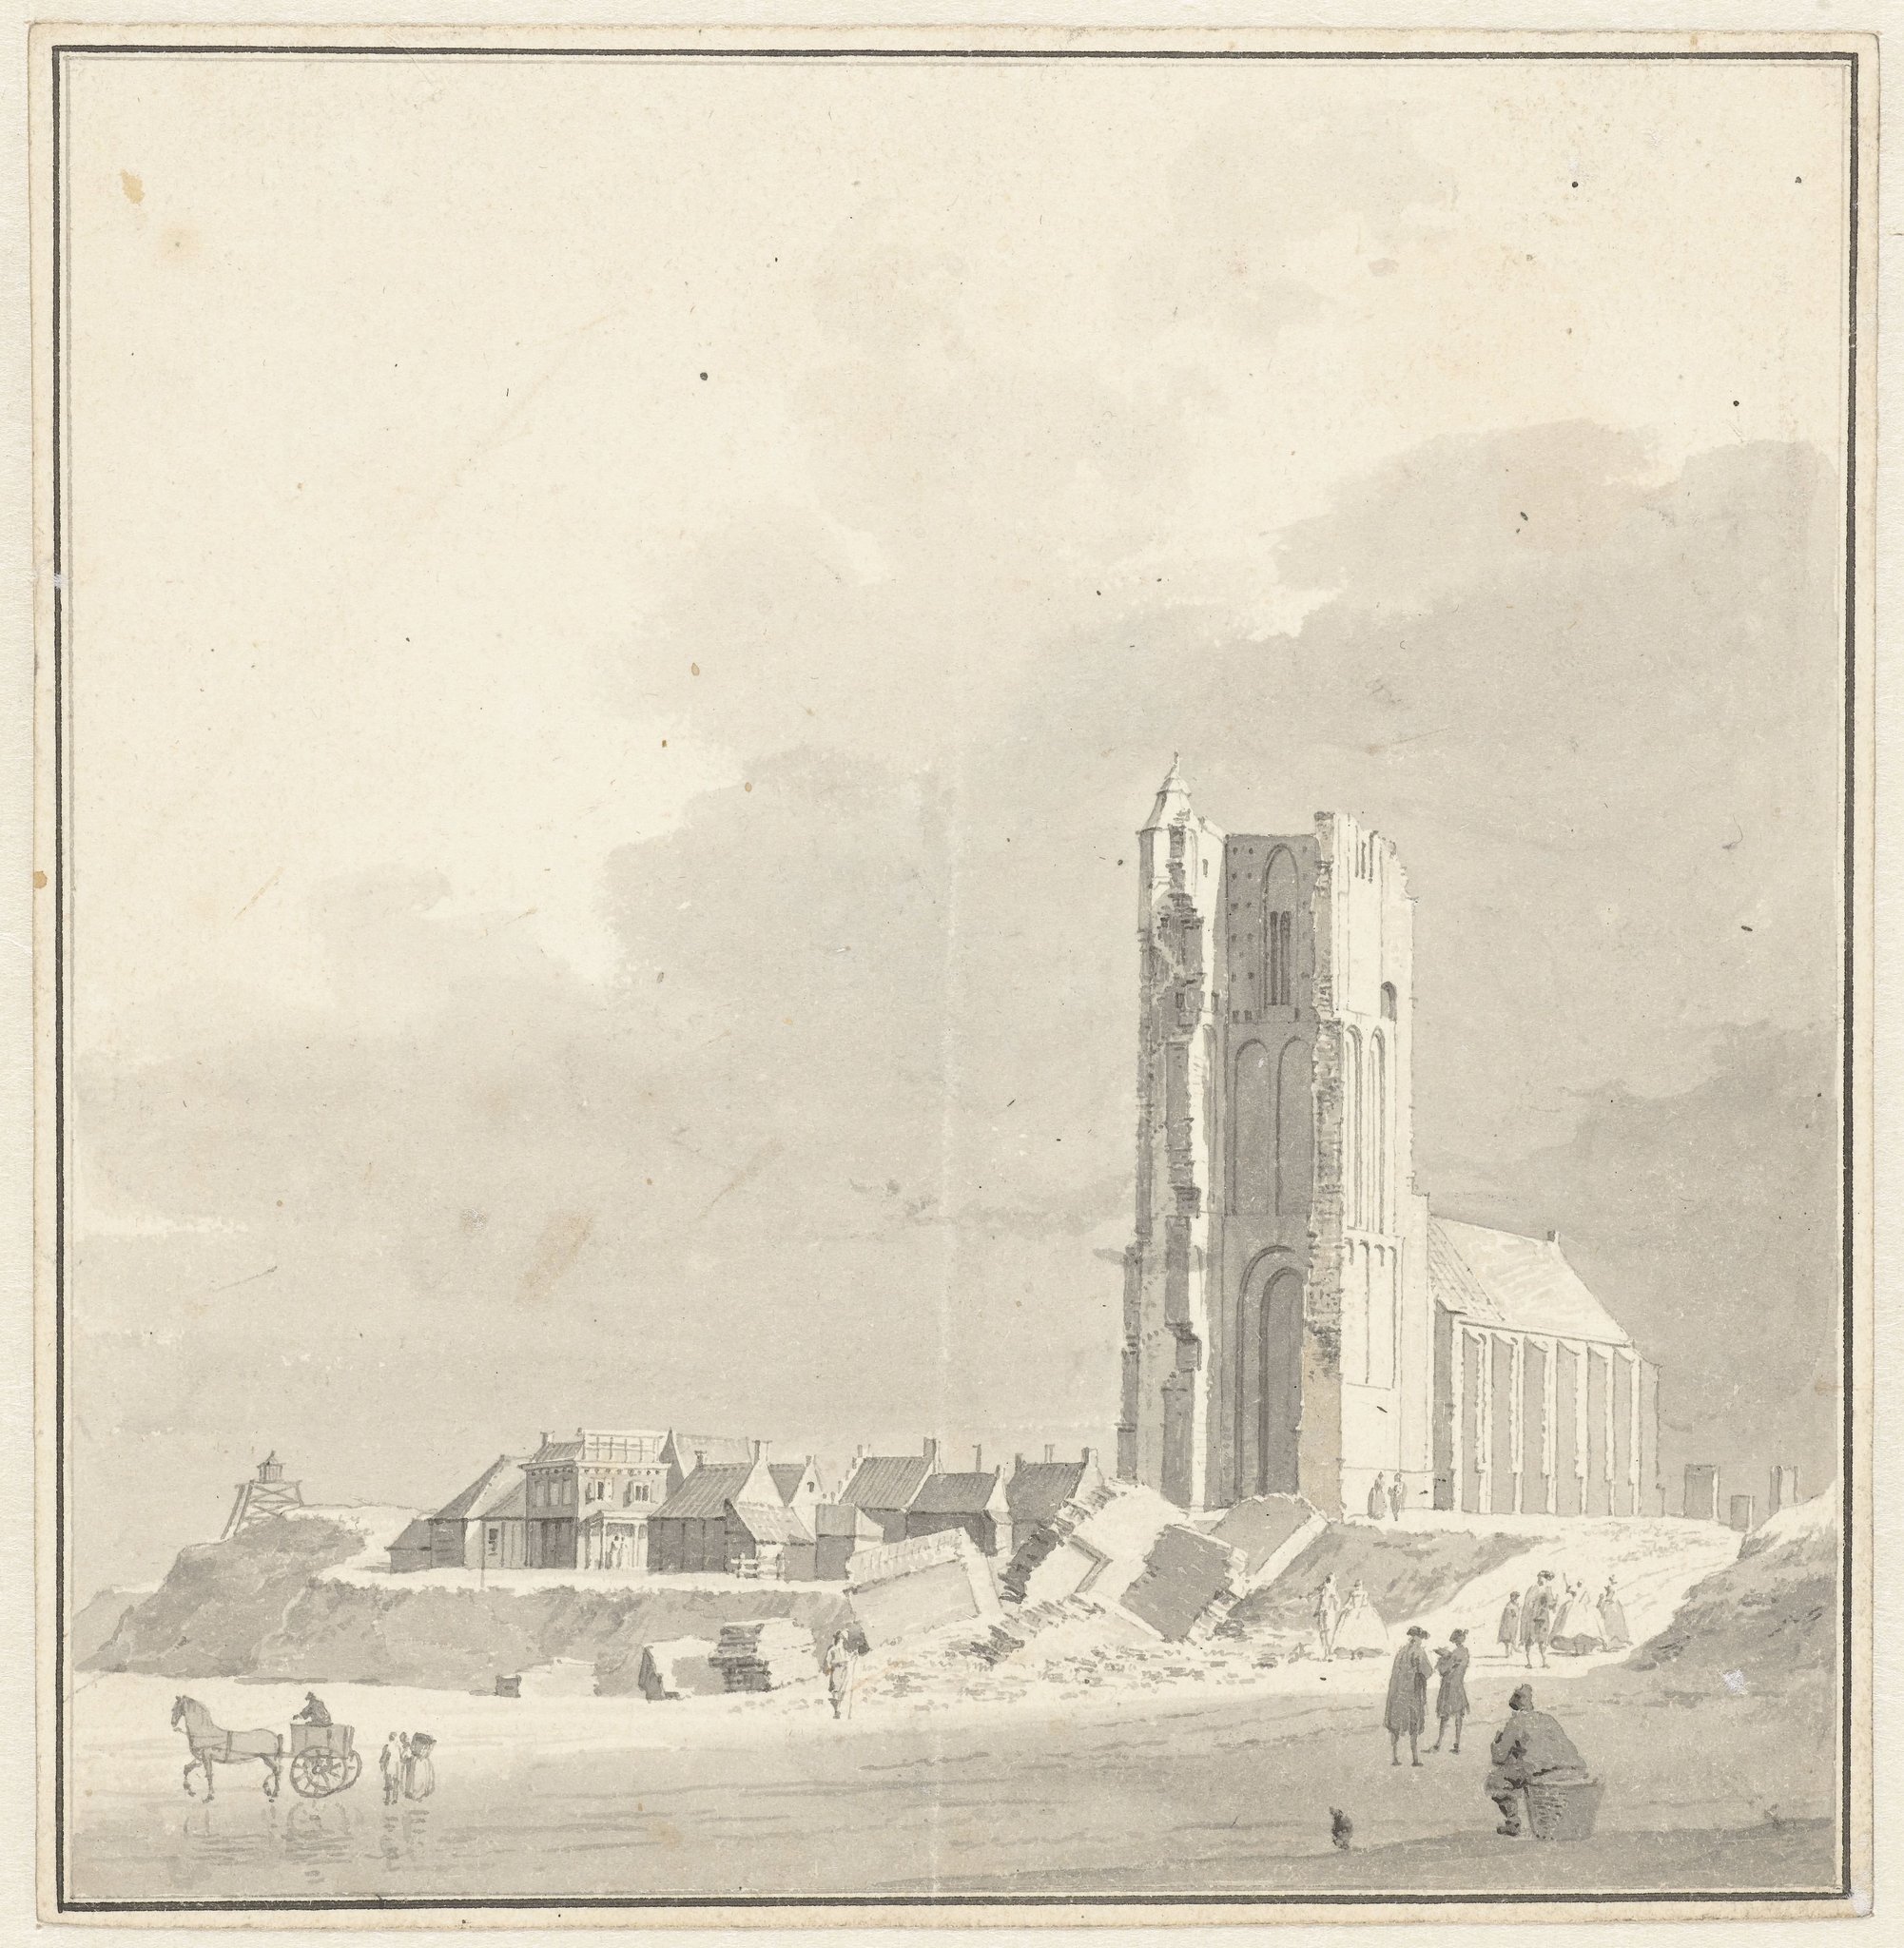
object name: drawing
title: Gezicht op Egmond aan Zee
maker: cornelis pronk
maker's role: draughtsman, painter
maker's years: 1691-1759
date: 1701-1759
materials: ink, paper, pencil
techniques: brush, pen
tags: city-view, and landscape with man-made constructions, church (exterior)